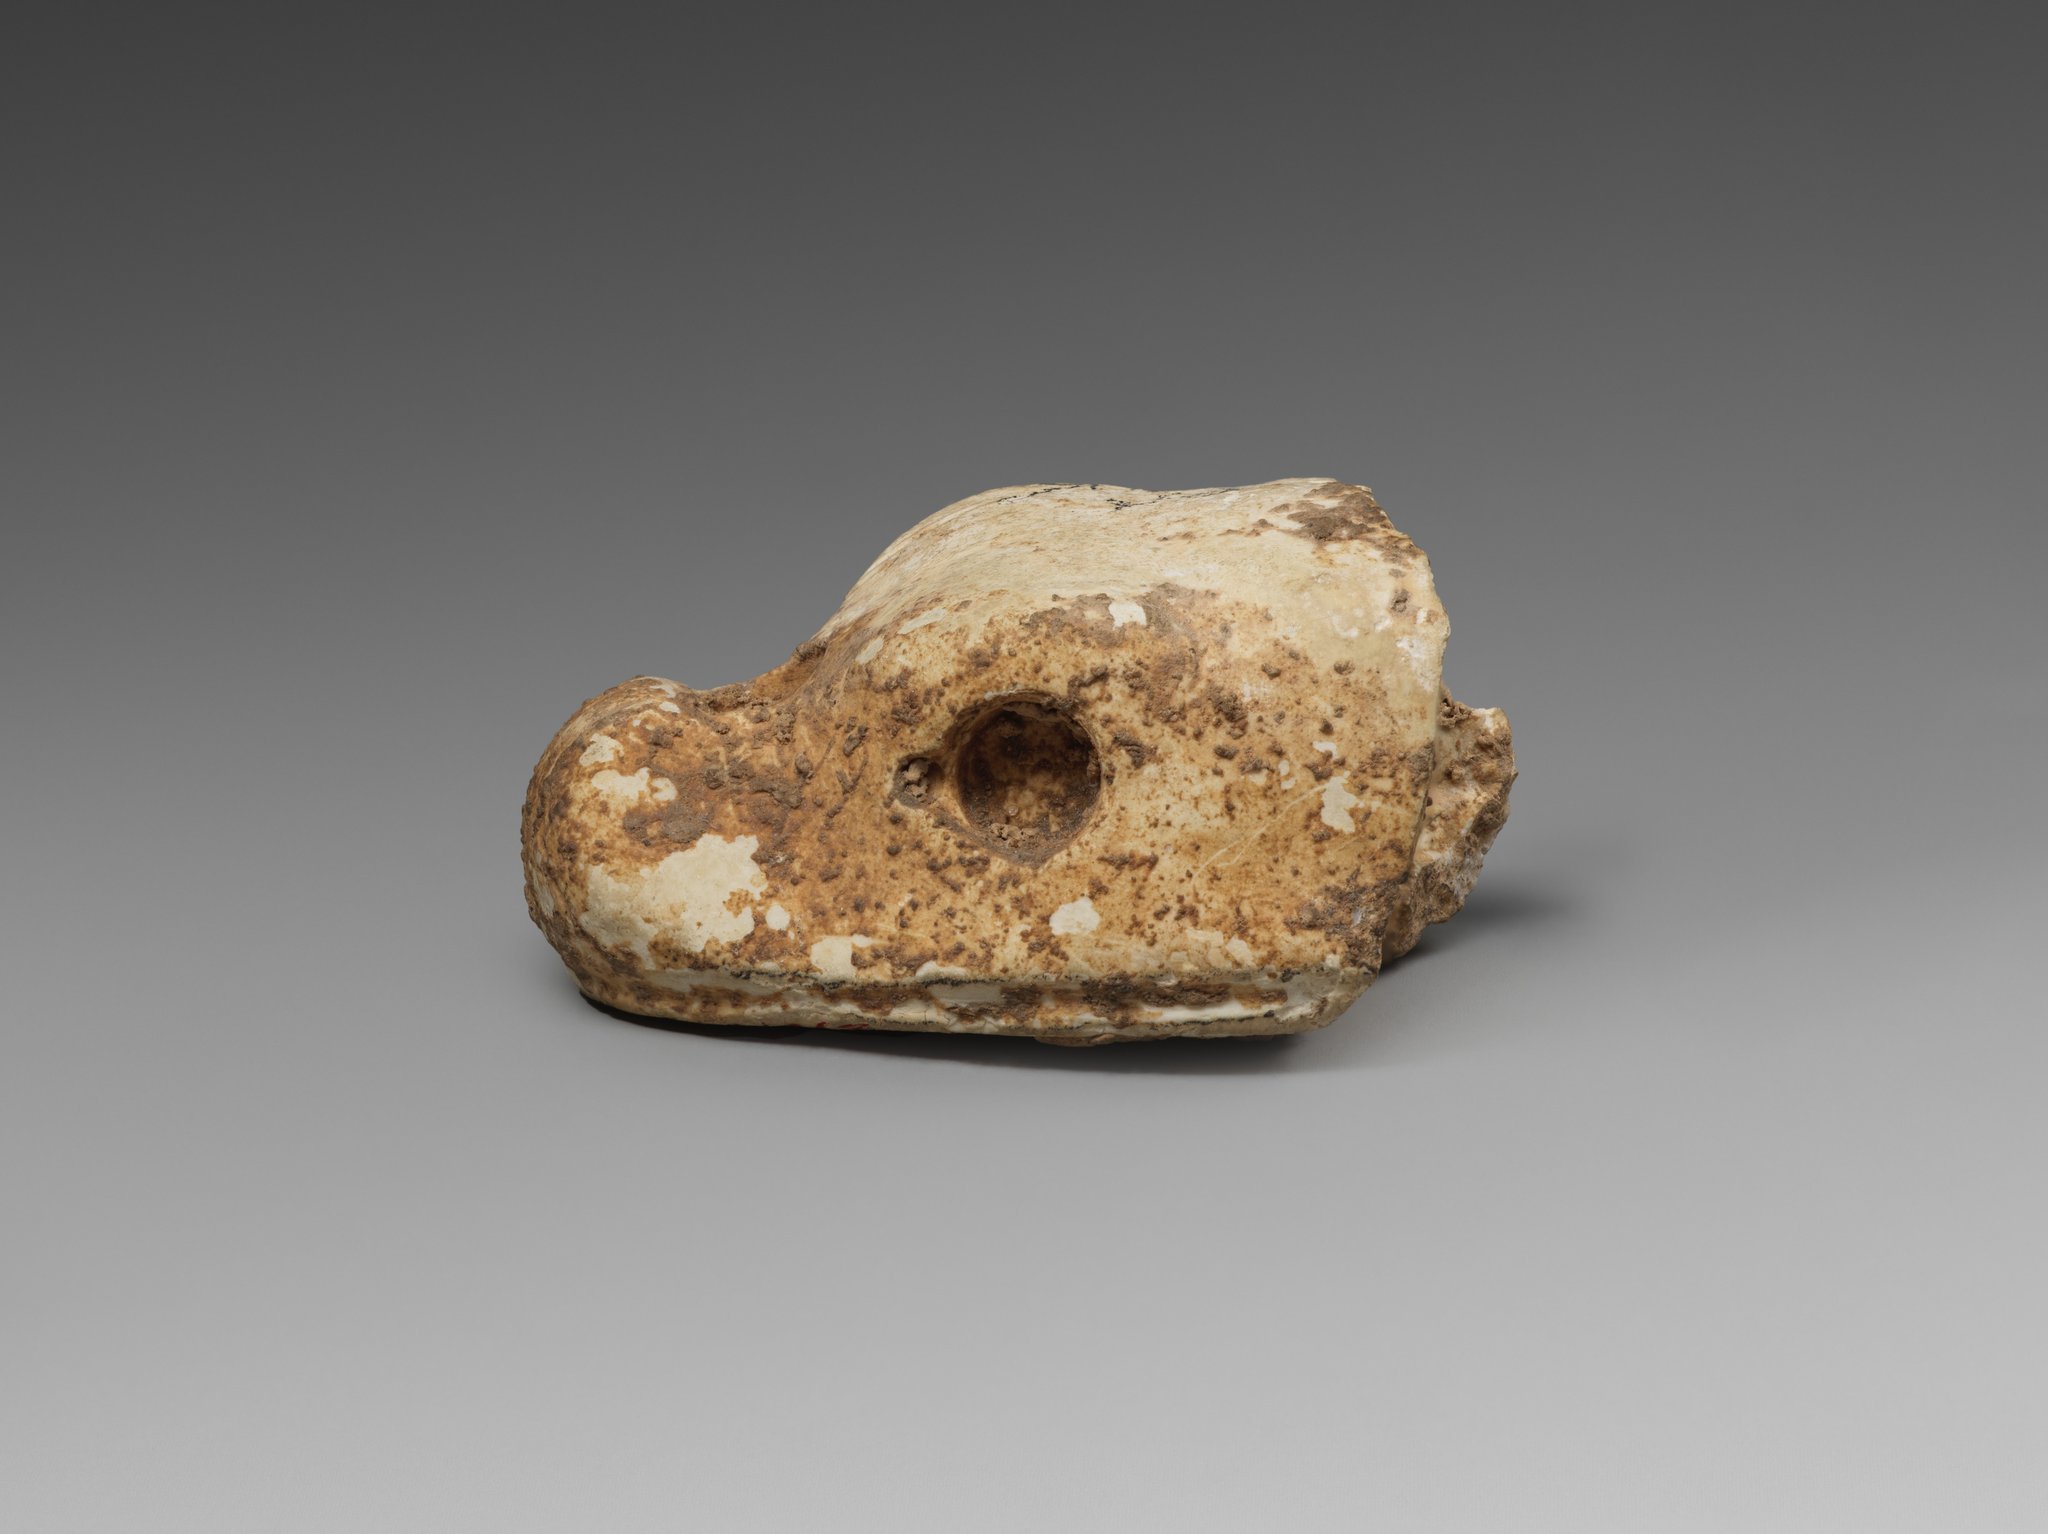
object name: sculpture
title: Head of mushhushshu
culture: assyrian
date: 900-801 BCE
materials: stone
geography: mesopotamia